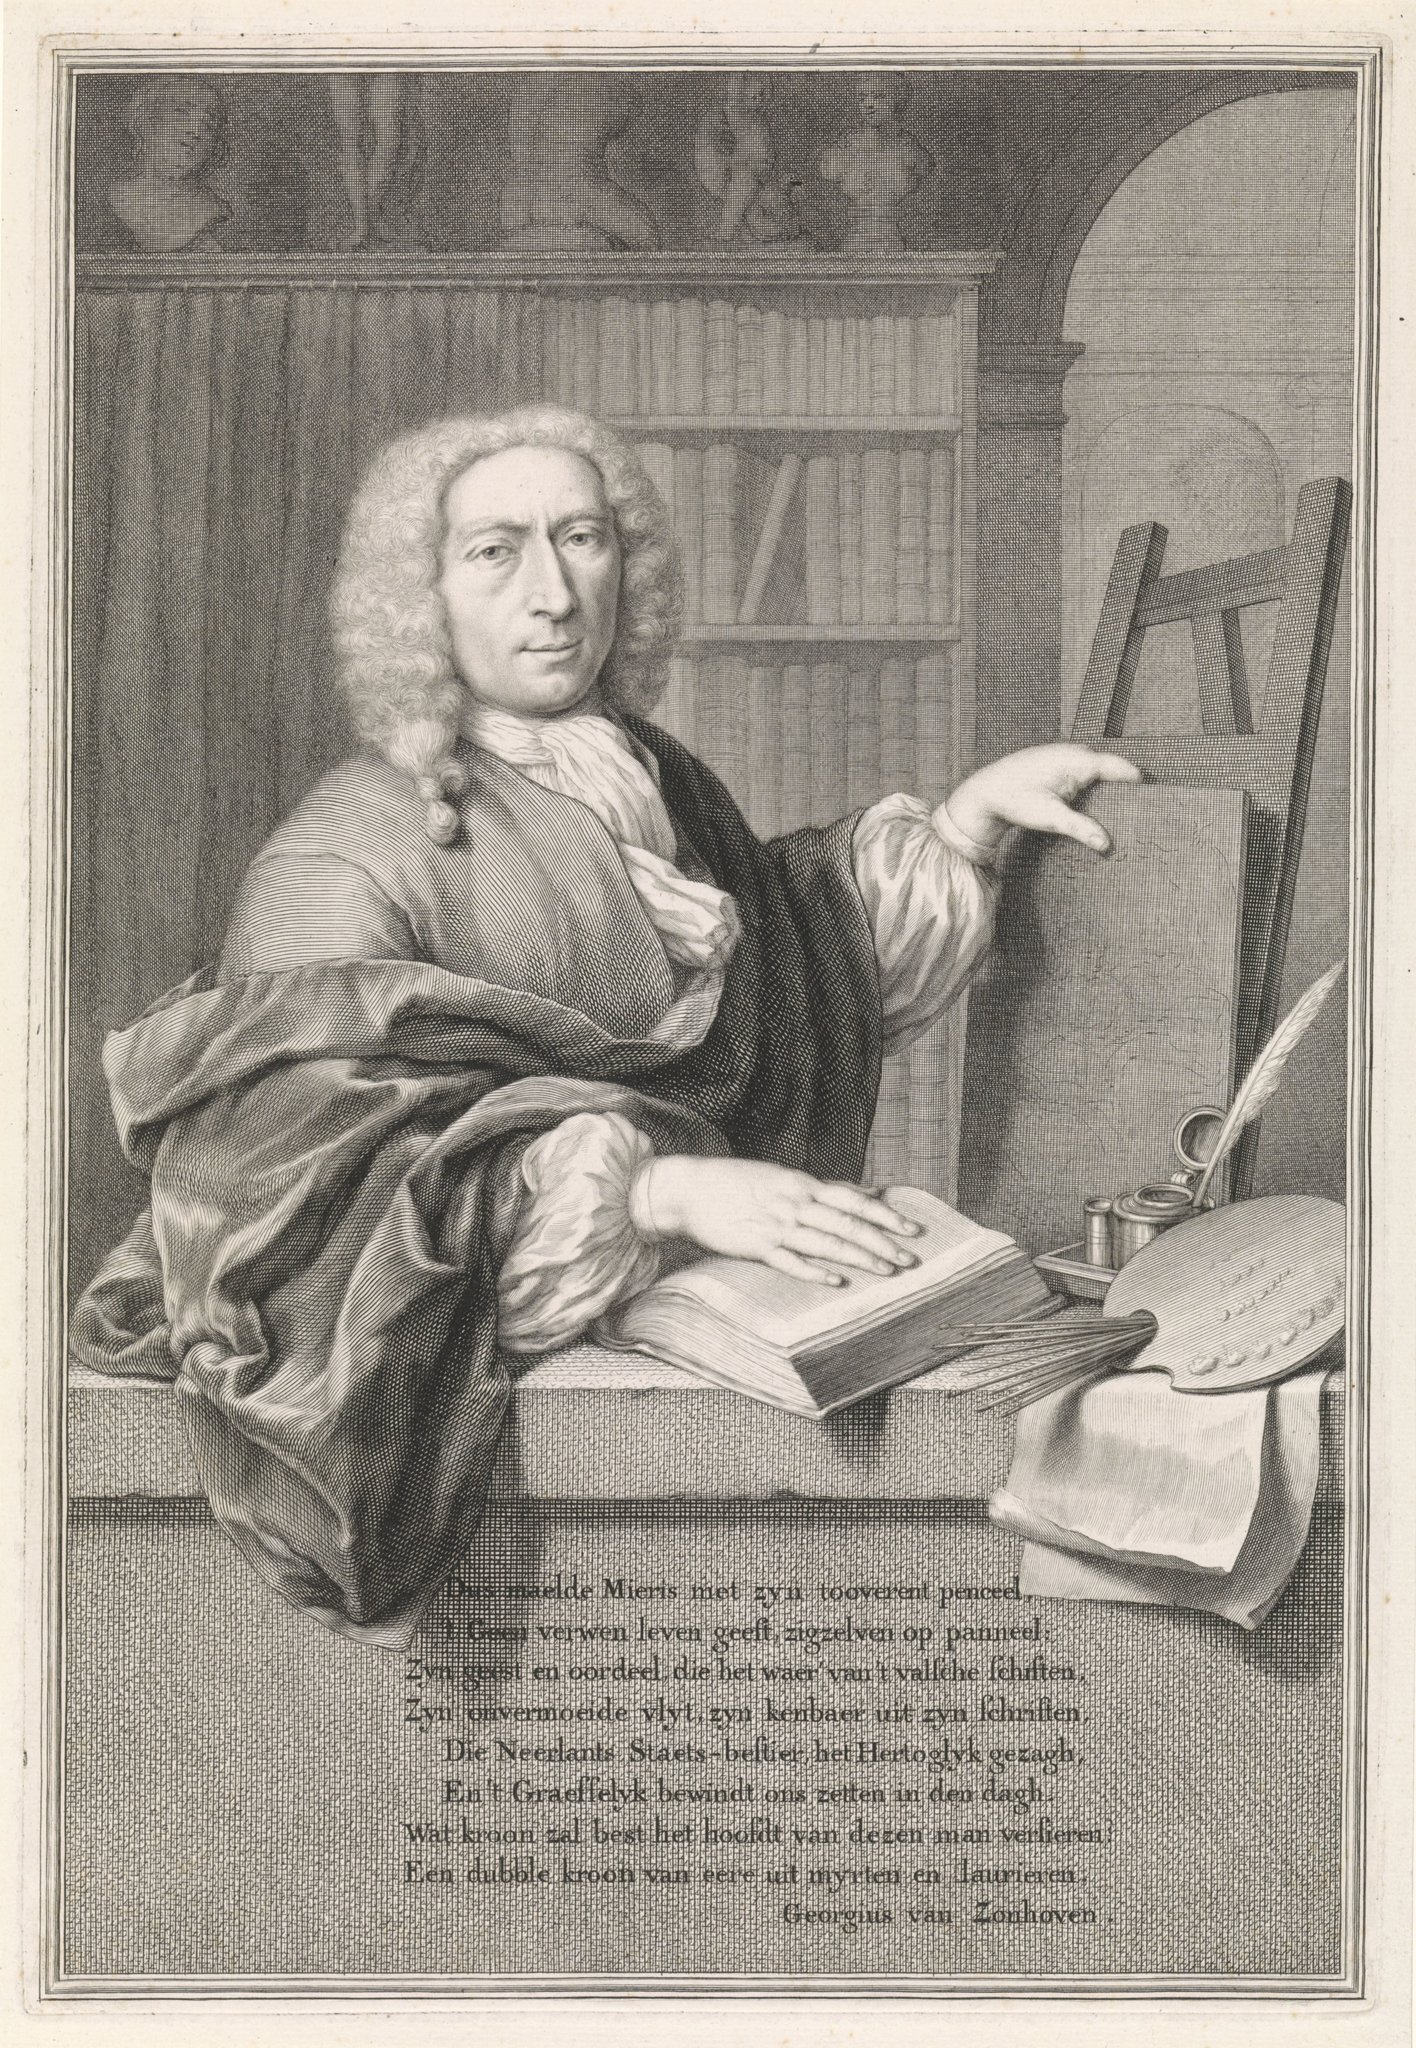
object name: print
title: Portret van Frans van Mieris (II)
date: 1708-1780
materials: paper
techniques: engraving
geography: amsterdam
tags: frans van mieris (ii), portrait, self-portrait of painter, tools, implements of painter, easel, artist at work, in his workshop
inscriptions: collector's mark: Lugt 240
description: Frans van Mieris (II) in een interieur van een atelier. Met zijn linkerhand houdt hij een schilderij vast op een ezel. Voor hem een plint waarop een opengeslagen boek, schildersattributen en schrijfgerei. Op de achtergrond een boekenkast waarop enkele beelden. Onder het portret een achtregelig vers in het Nederlands.